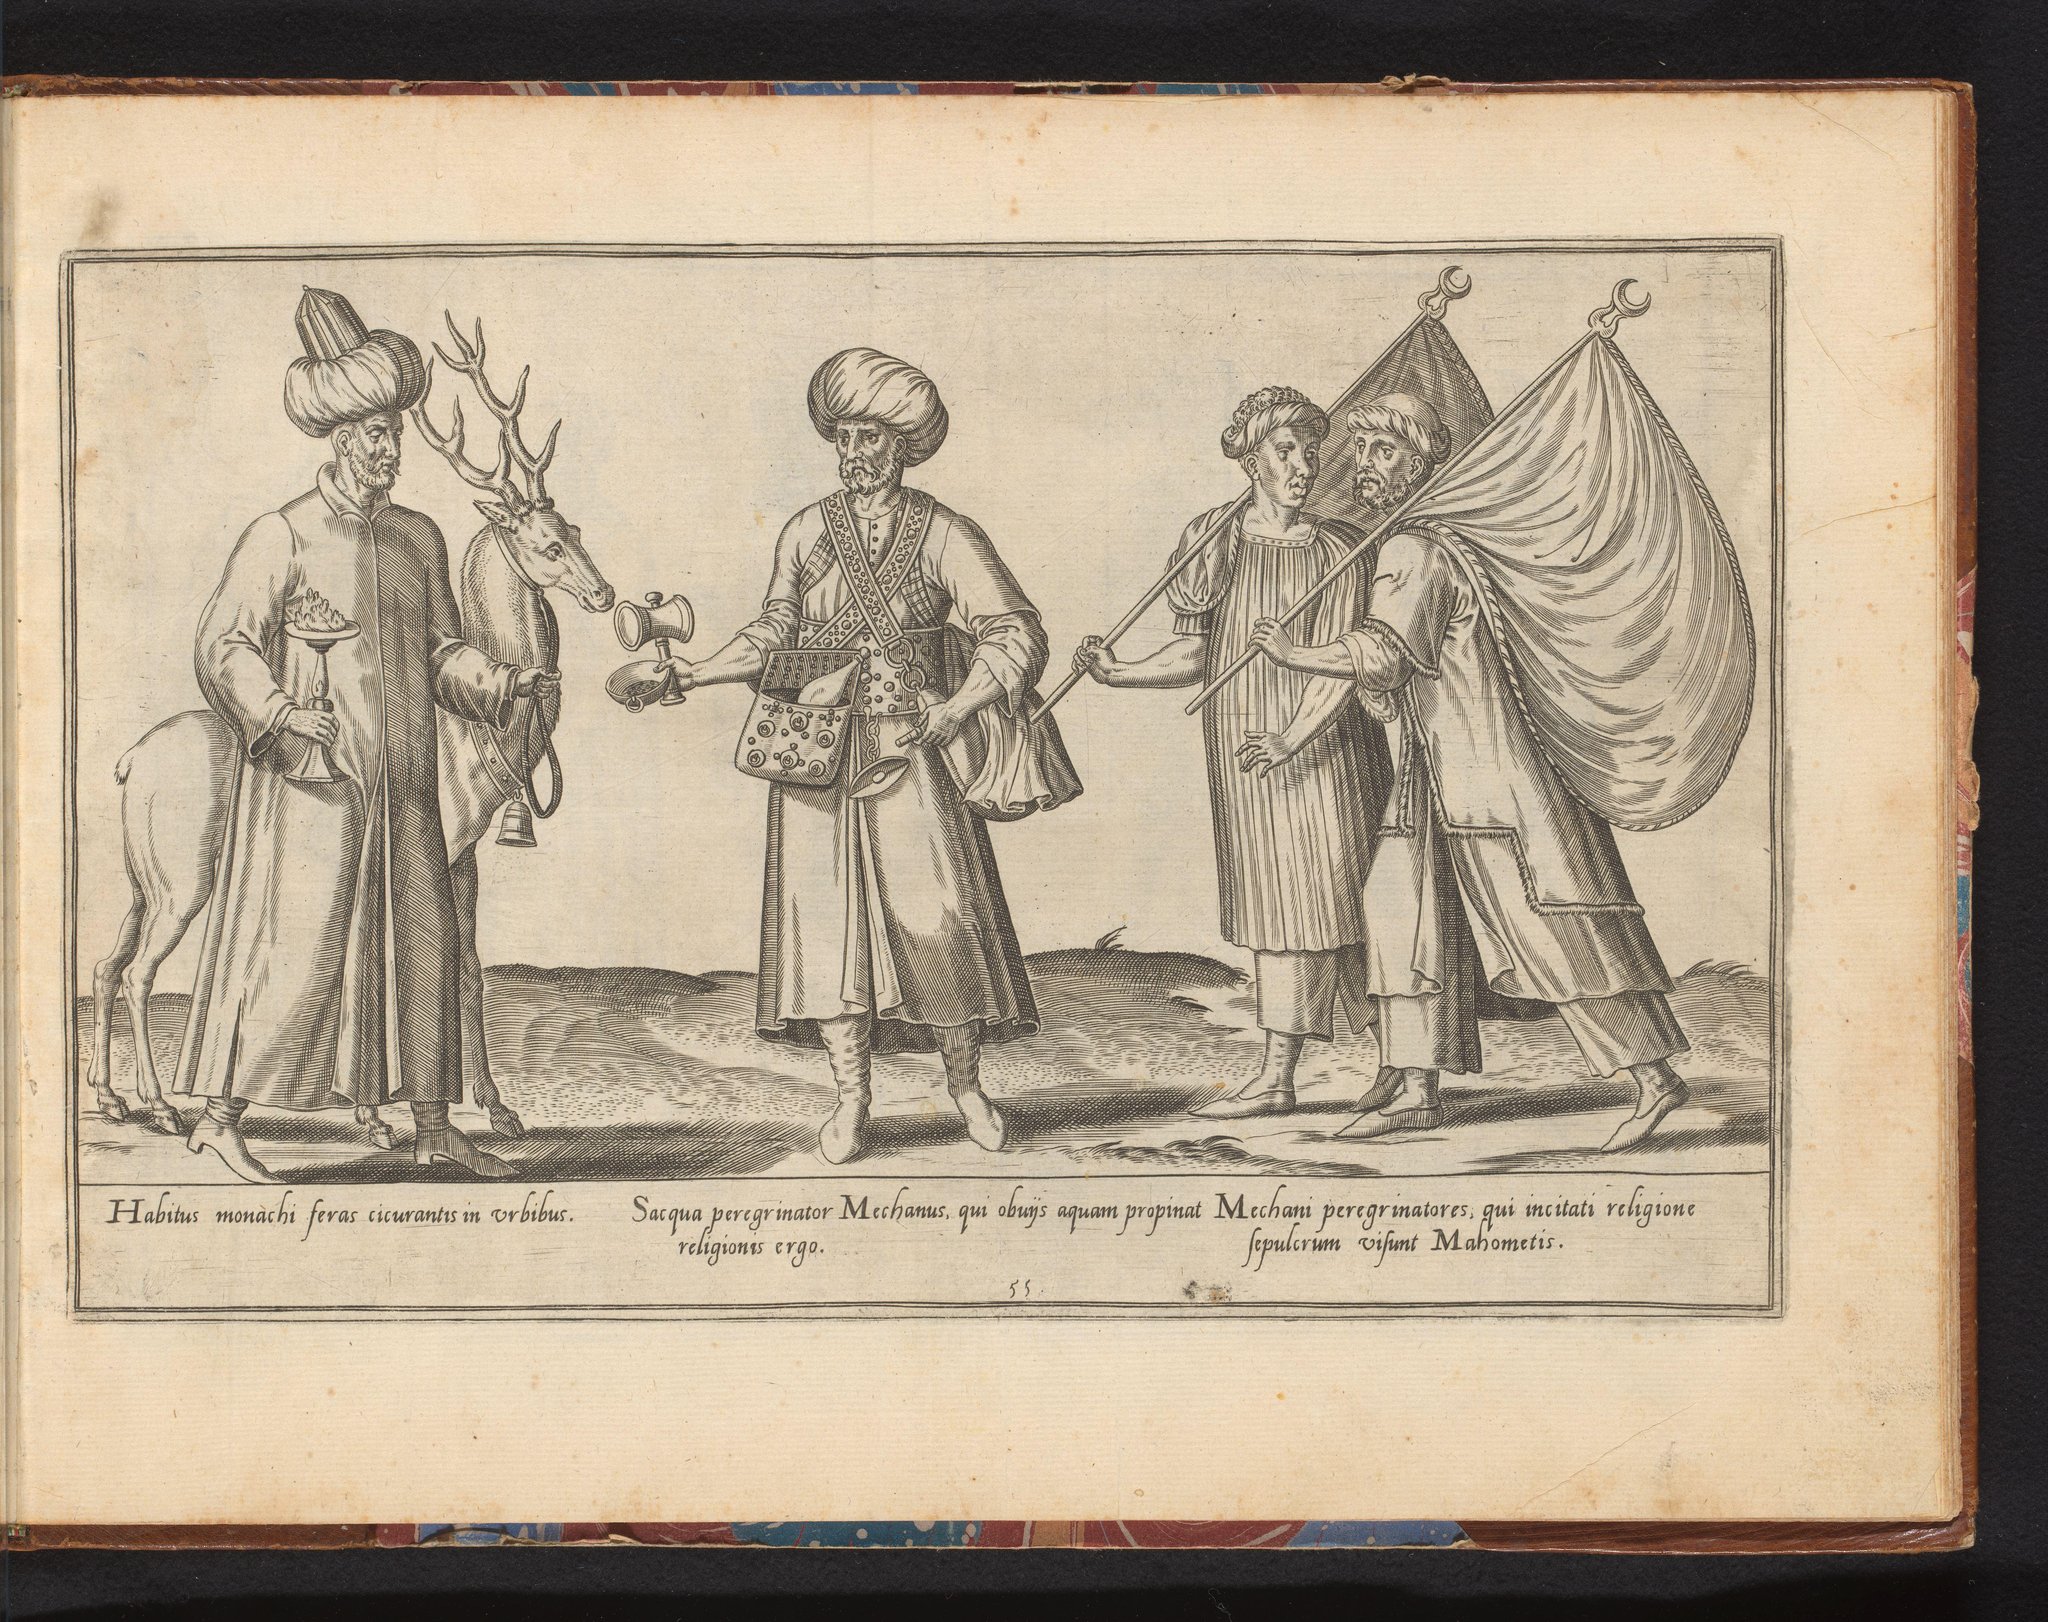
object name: costume print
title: Vier oosterse mannen, gekleed volgens de dracht van ca. 1580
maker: abraham de bruyn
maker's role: print maker, publisher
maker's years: 1540-1587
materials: paper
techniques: engraving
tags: asiatic races and peoples (+ costume)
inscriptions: number: ‘55’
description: Prent uit het boek 'Omnium pene Europae, Asiae, Aphricae atque Americae gentium habitus...', 1581. De prent maakt deel uit van een album.